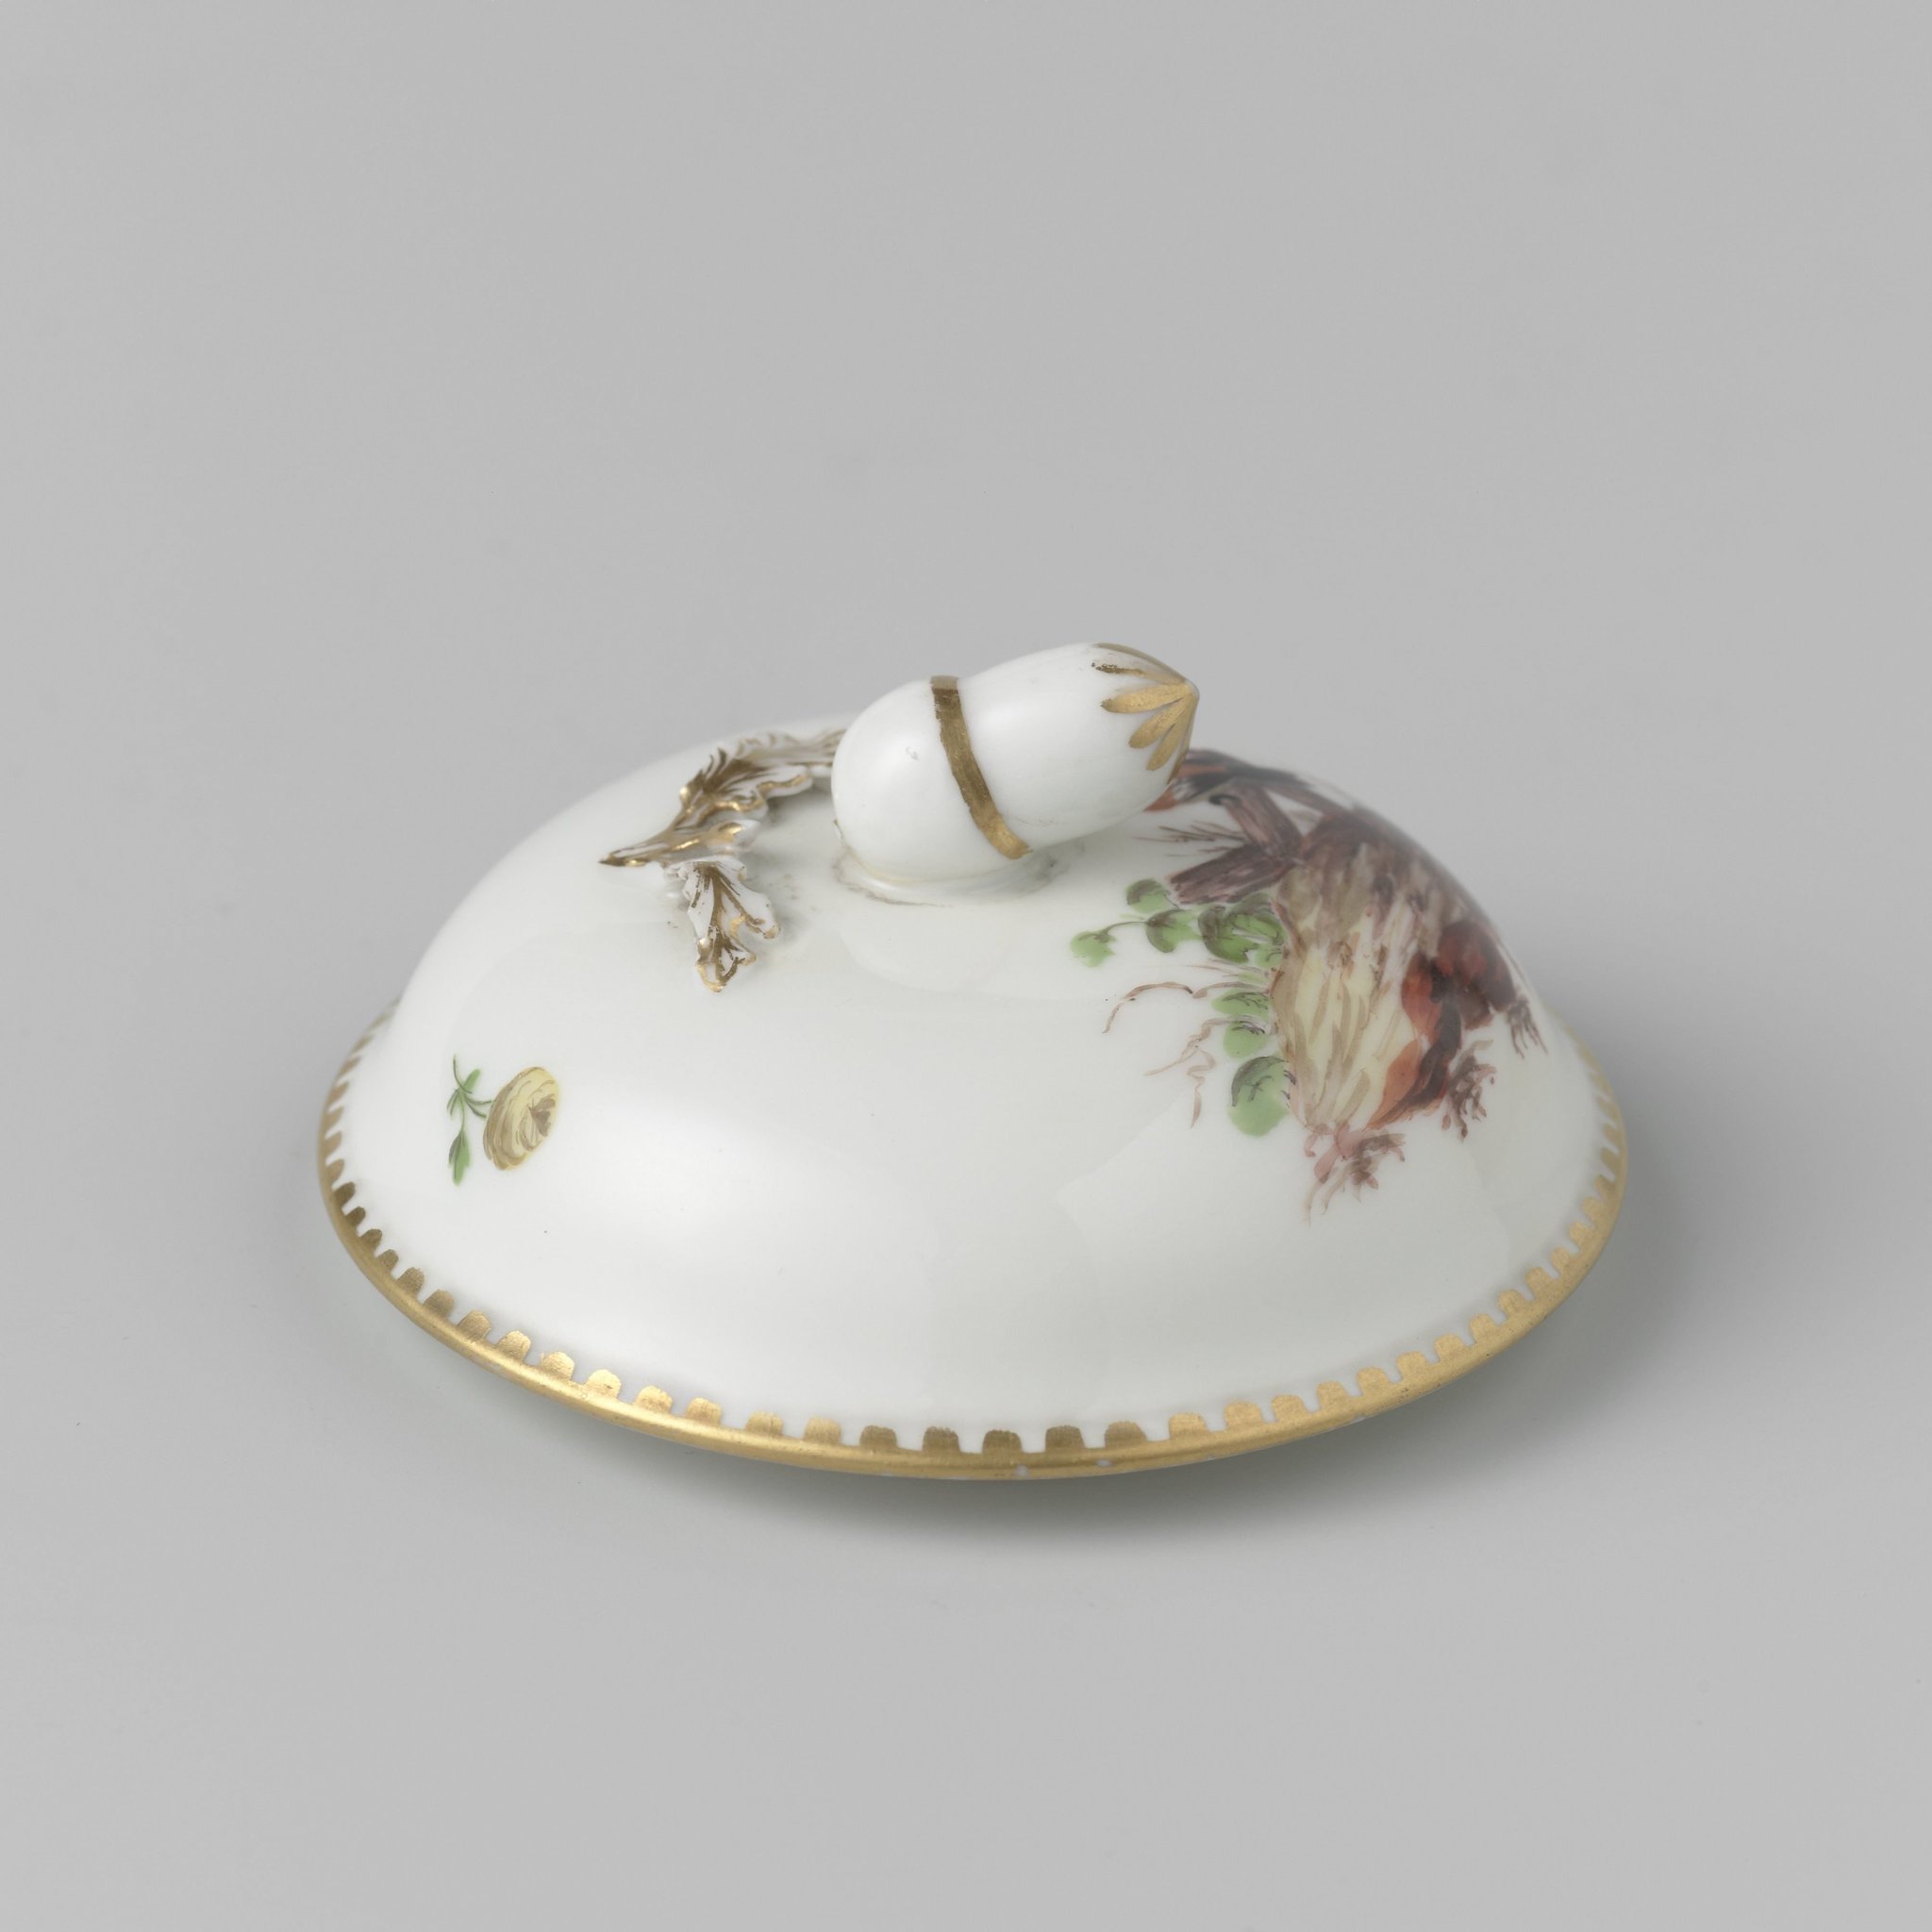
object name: lid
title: Coffee pot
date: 1784-1809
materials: porcelain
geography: meissen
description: lid: Meissener Porzellan Manufaktur pot: Porceleinfabriek aan den Amstel Manufactuur Oud-Loosdrecht Ouder-Amstel and Loosdrecht, c. 1784–1809 hard-paste porcelain